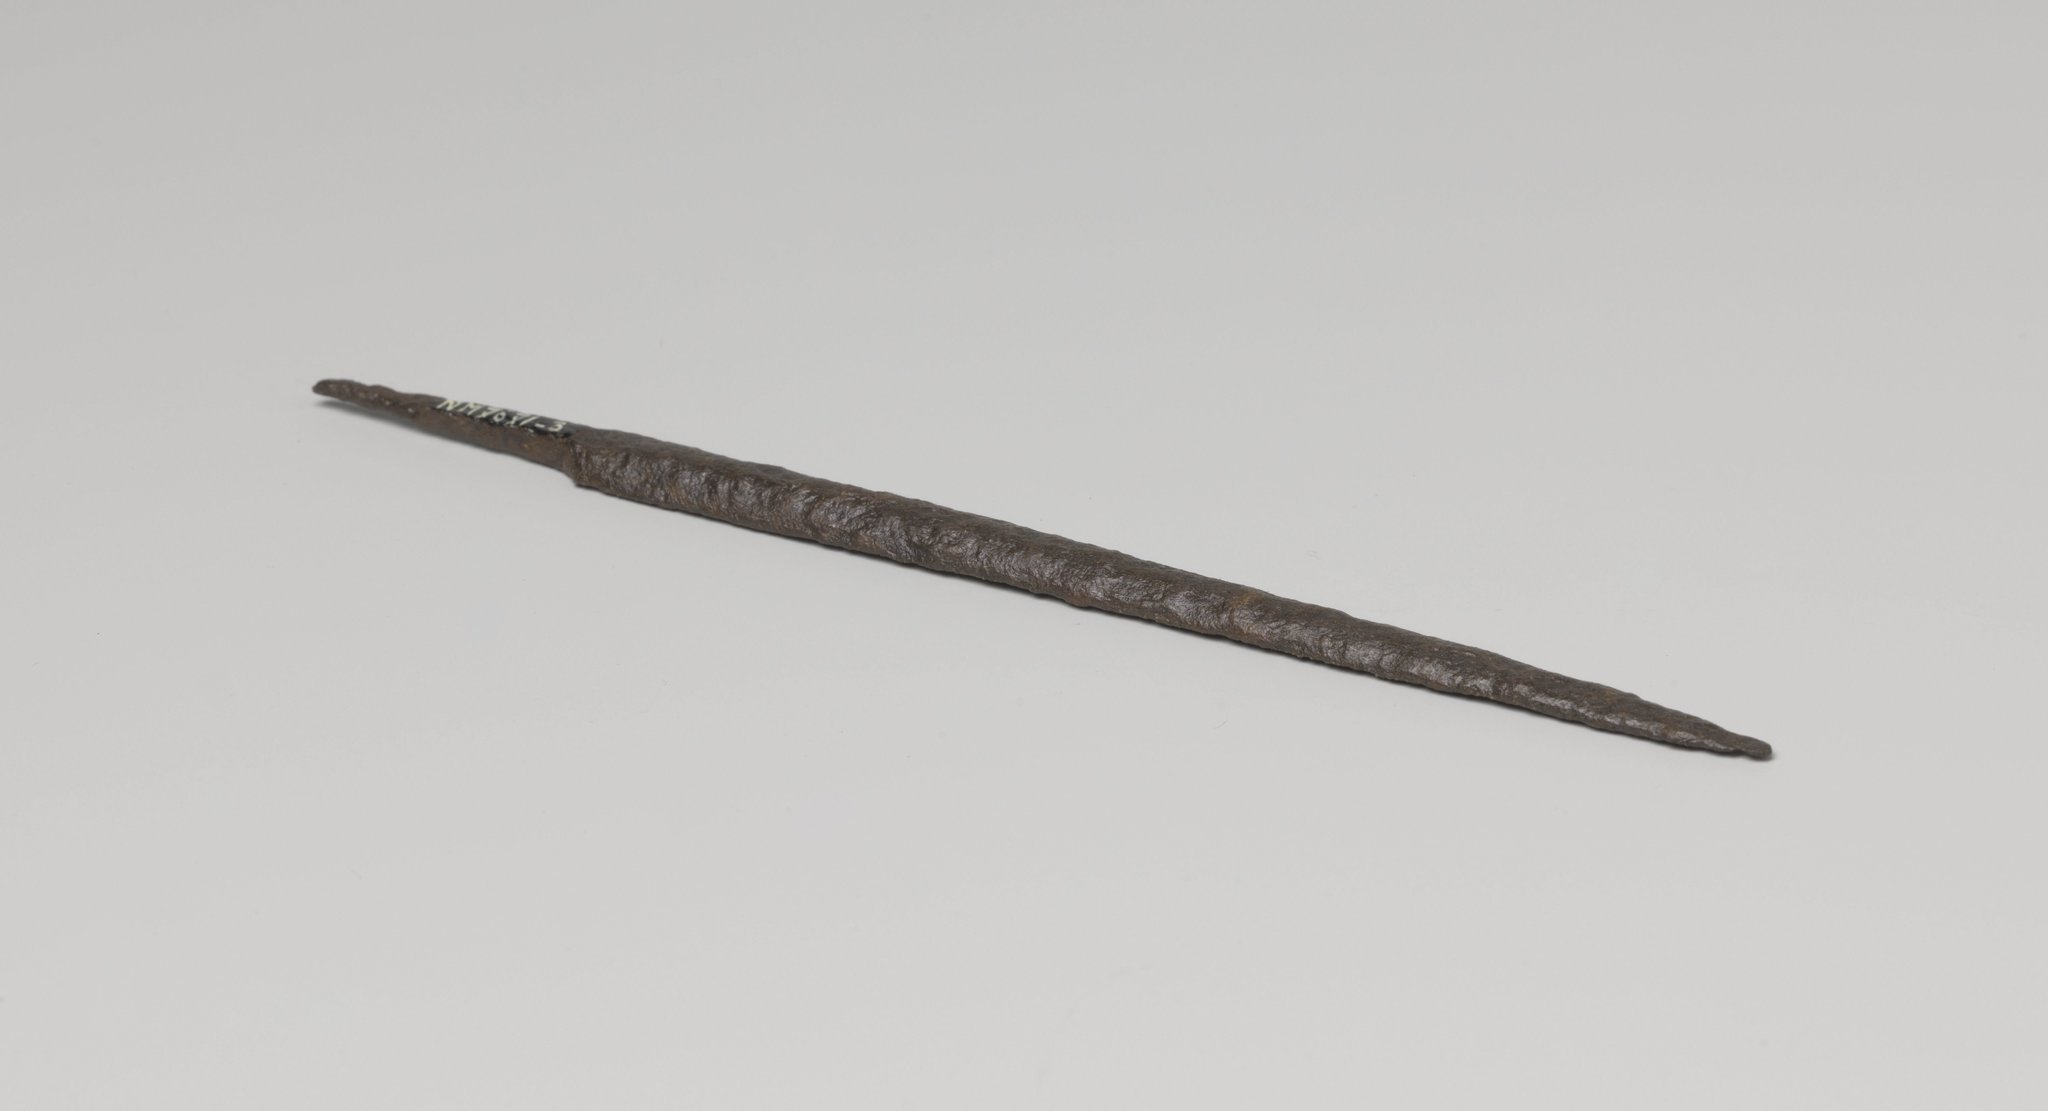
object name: file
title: Vijl, half rond zonder handvat, met evenwijdige inkervingen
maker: Anonymous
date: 1590-1596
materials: iron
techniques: forging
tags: willem barendsz., amsterdam, jacob van heemskerck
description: Semicircular and flat files and raspers